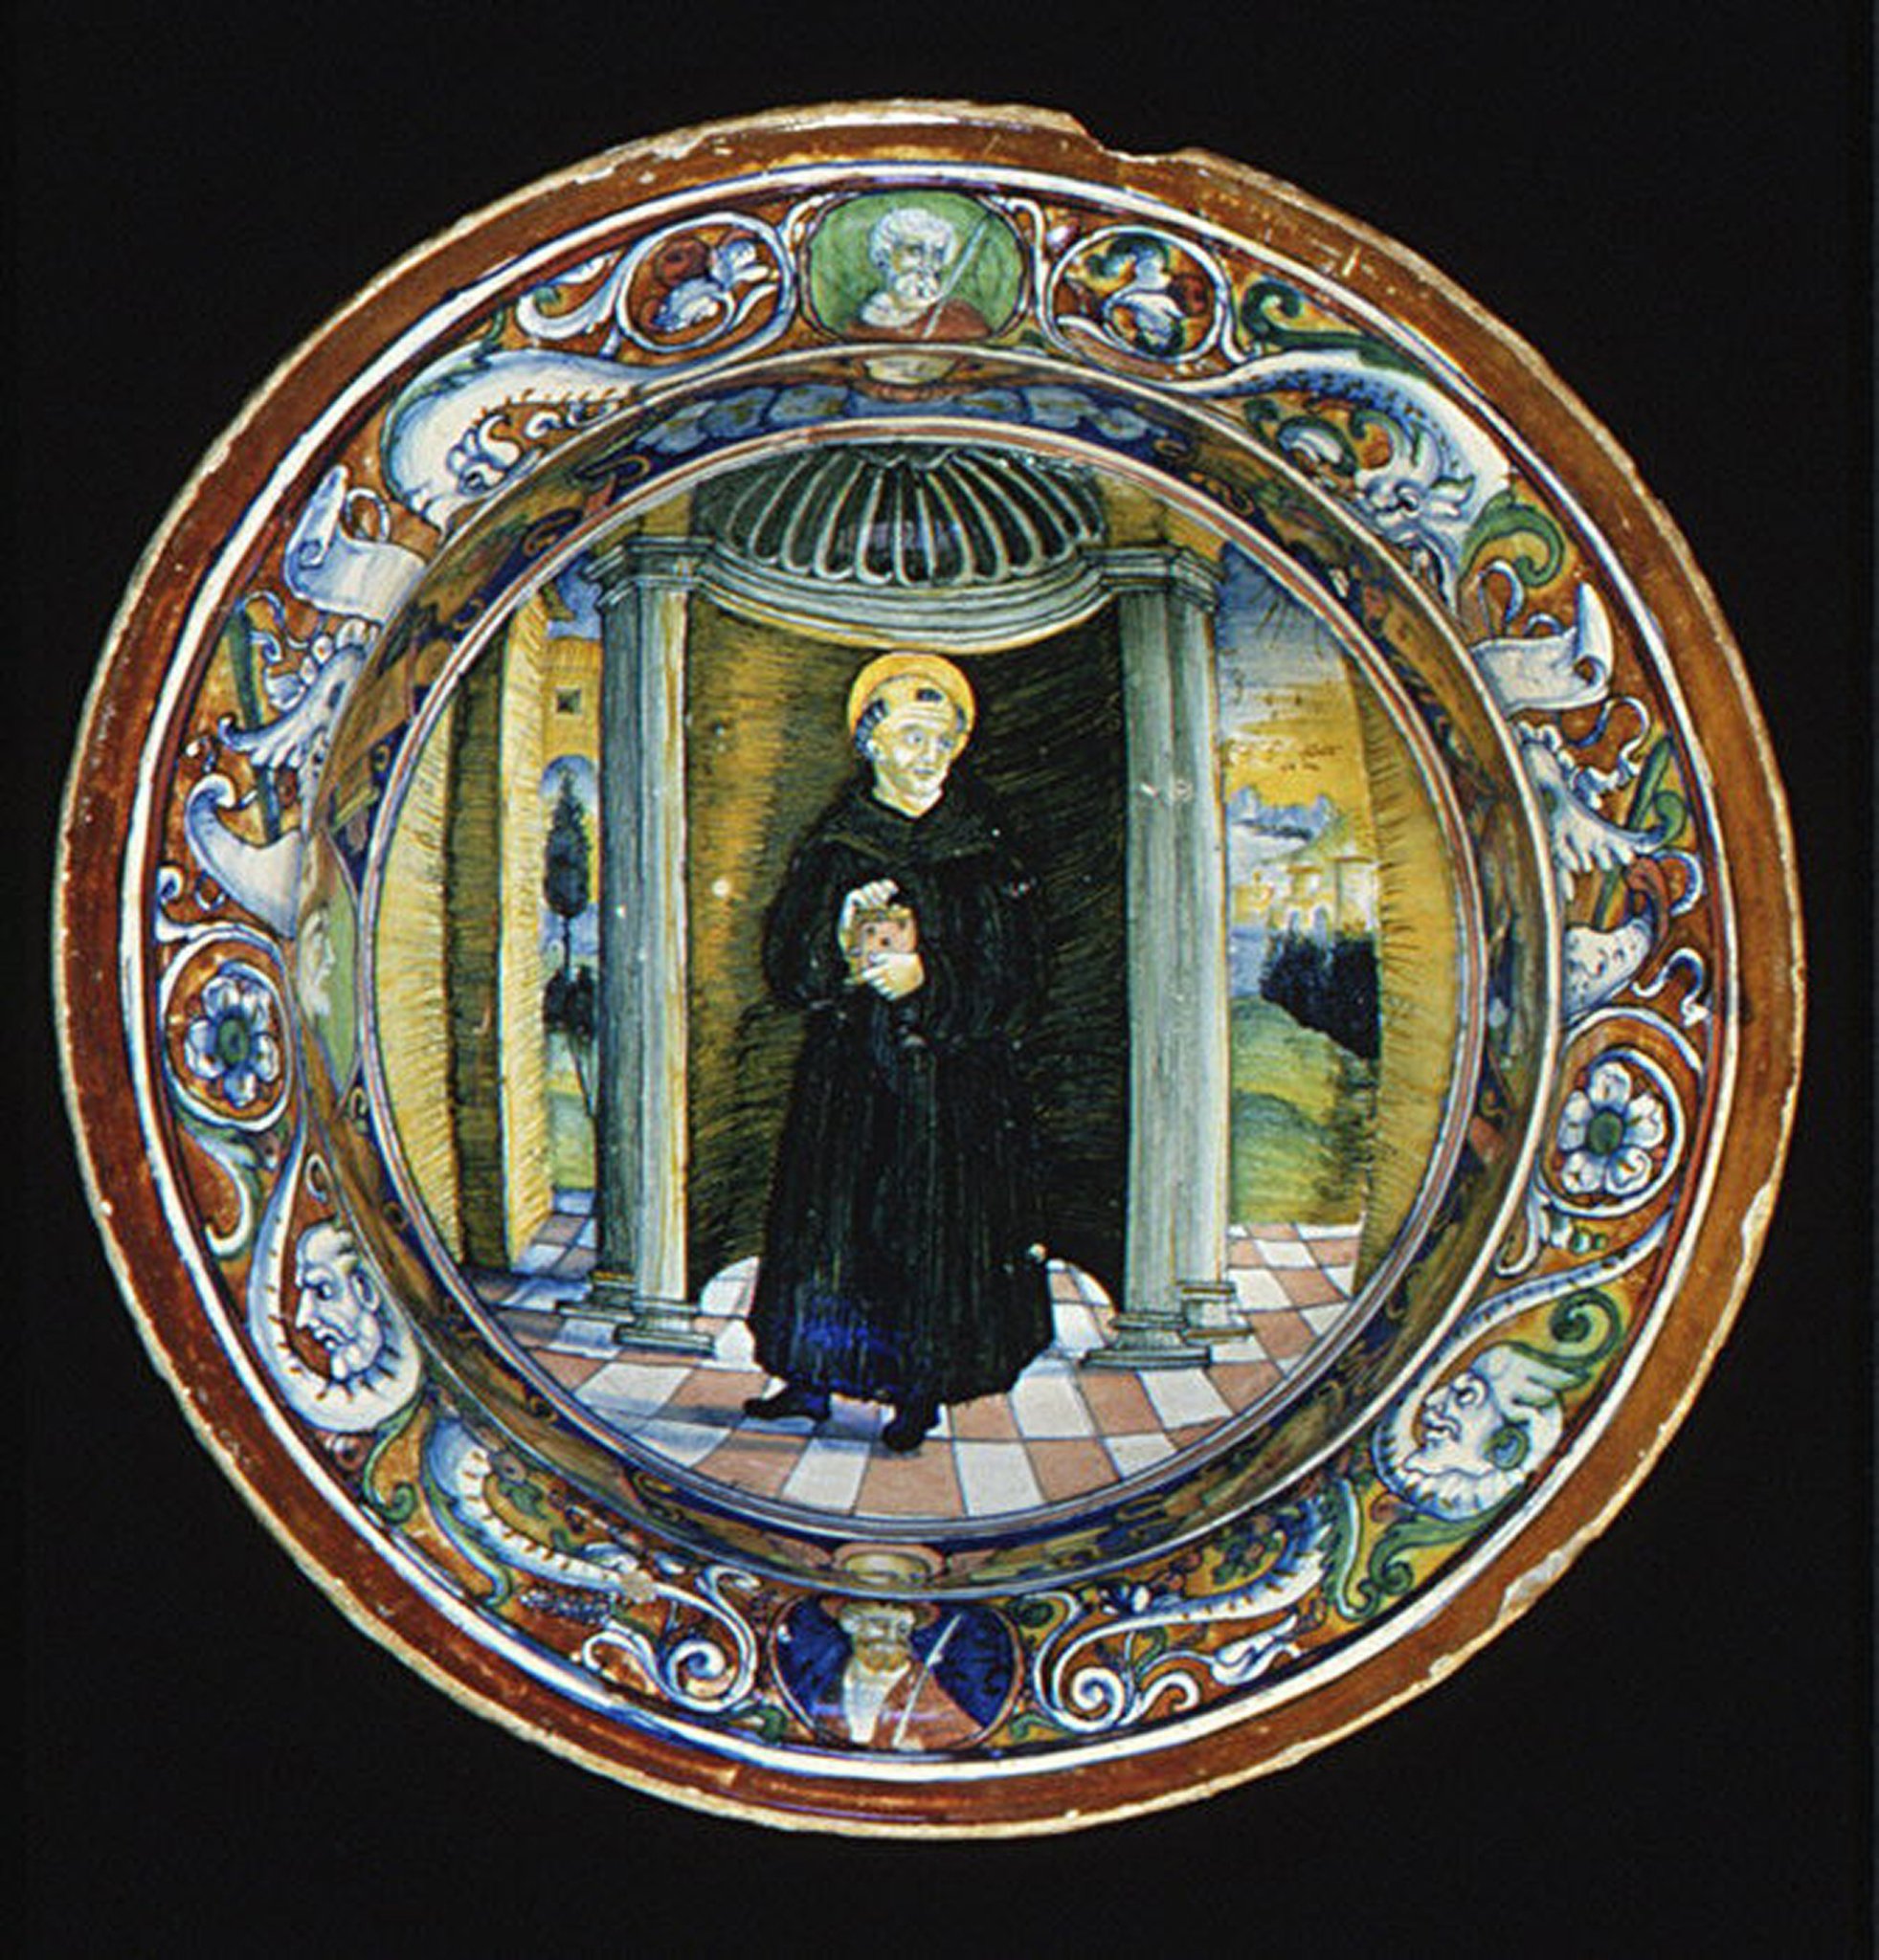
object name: bowl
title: Bowl with Saint Nicholas of Tolentino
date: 1524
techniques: maiolica, glazing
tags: men,saints